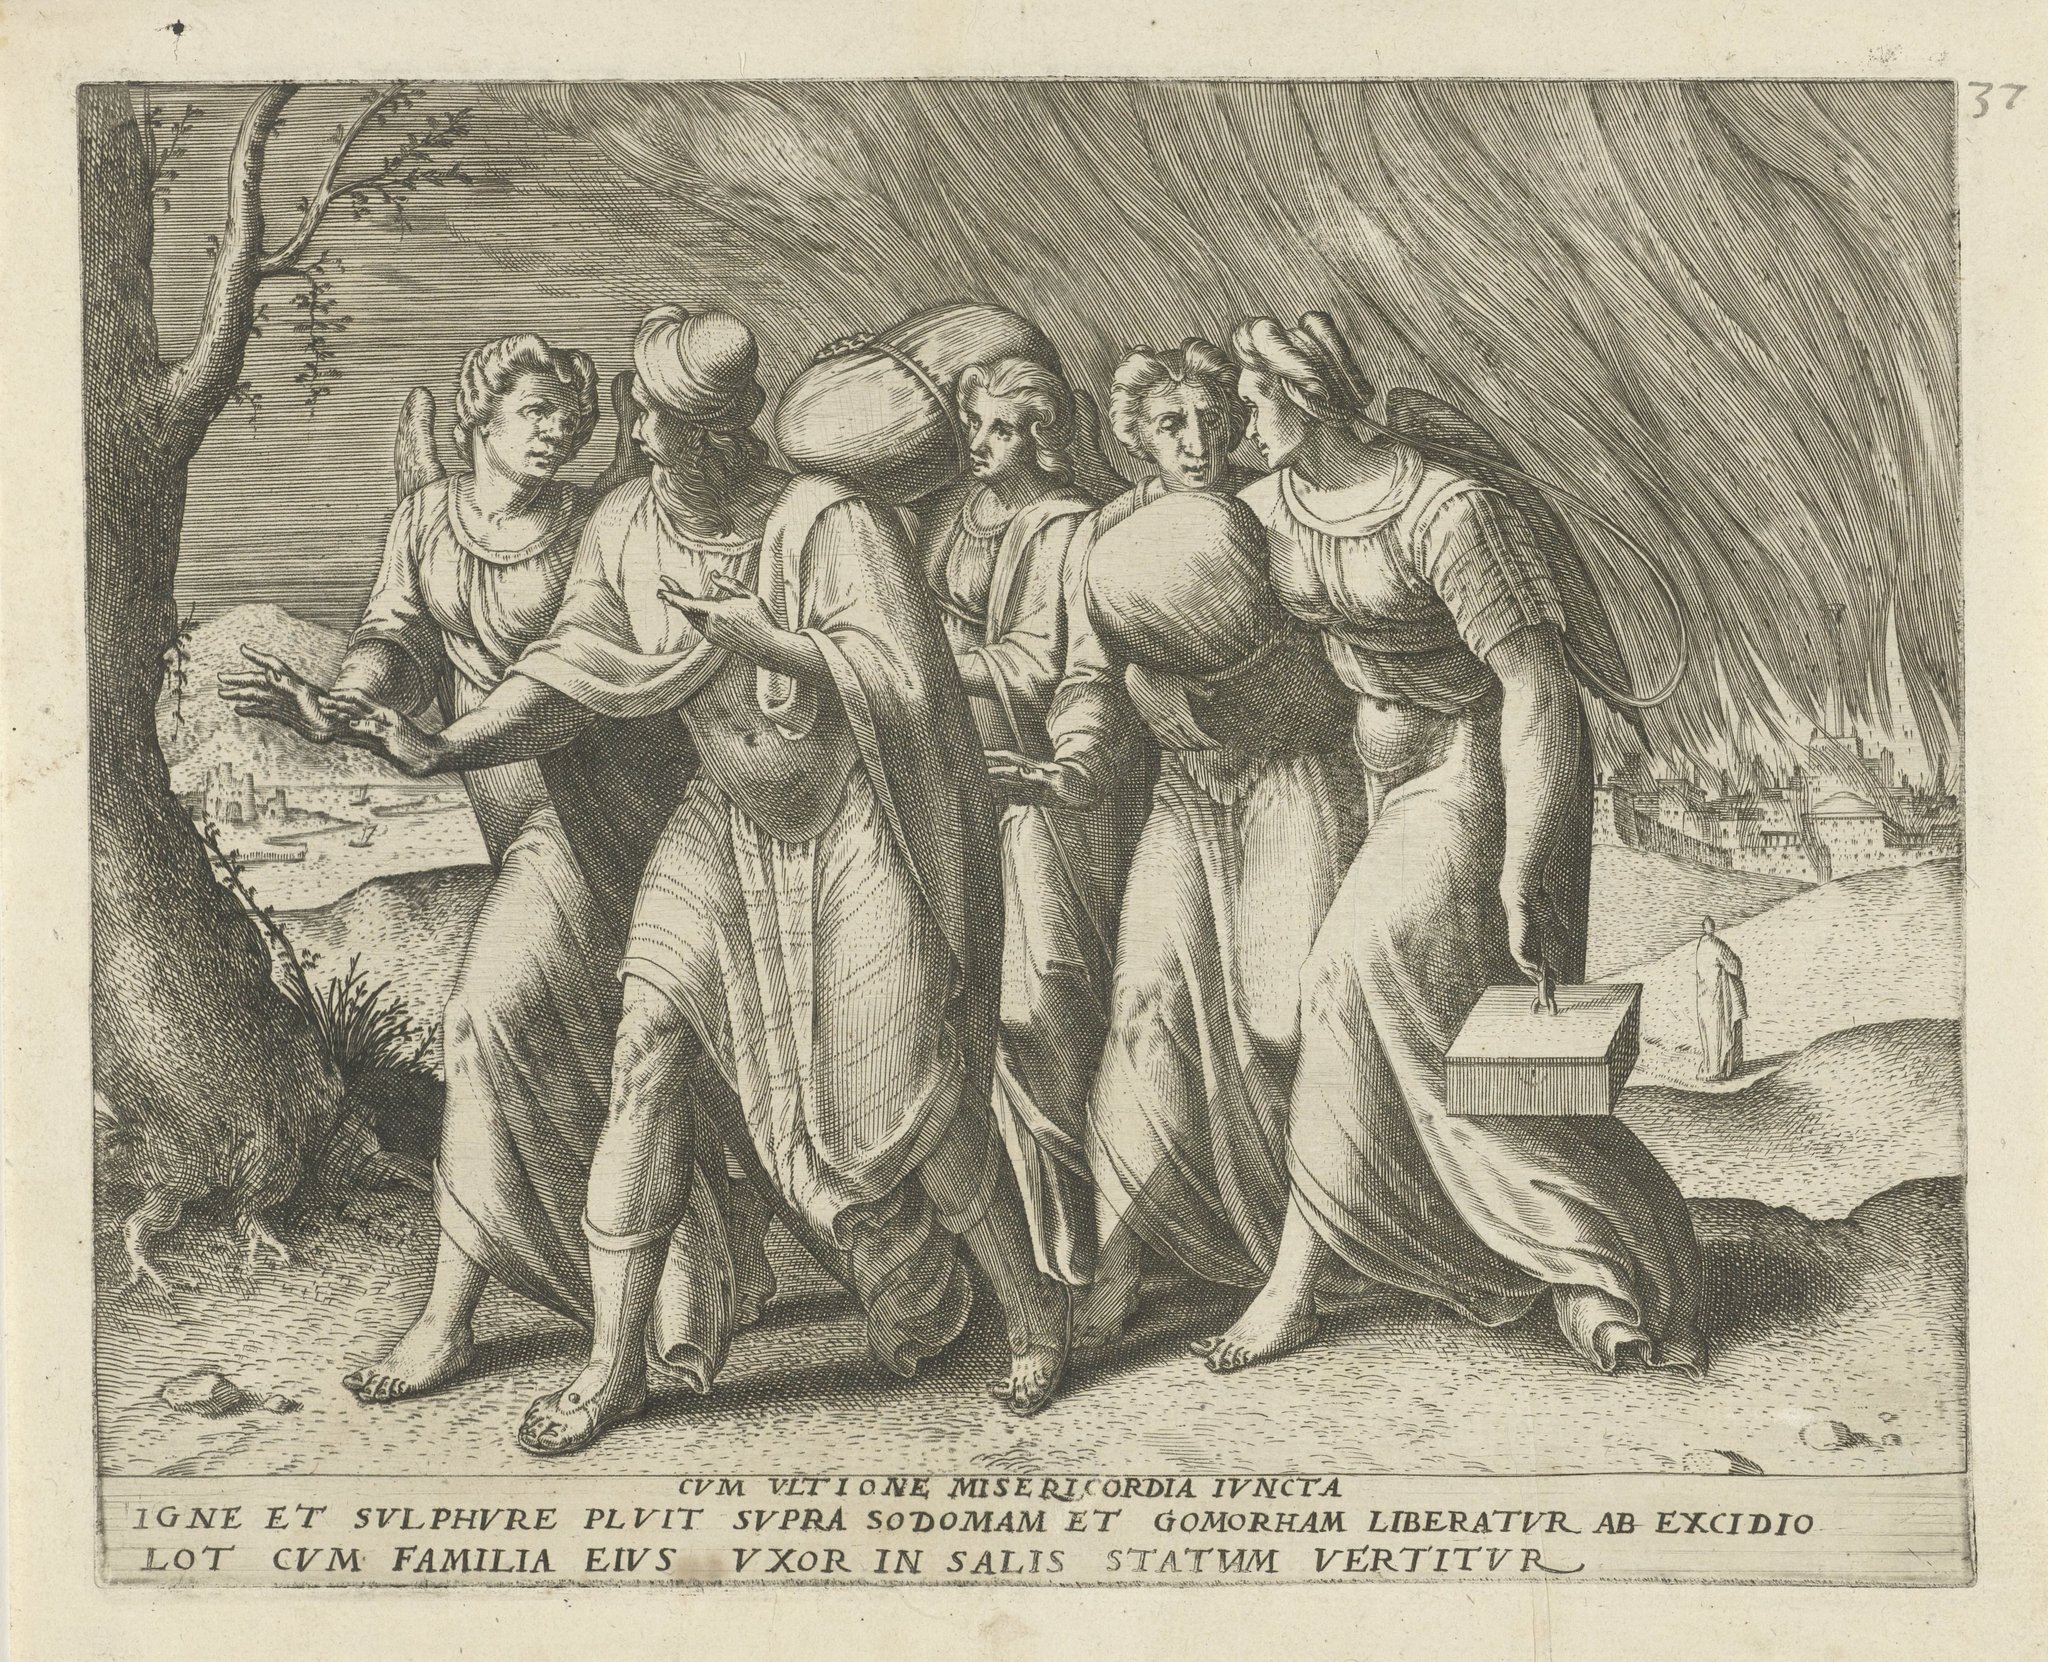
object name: print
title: Lot verlaat Sodom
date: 1550-1570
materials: paper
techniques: engraving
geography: antwerp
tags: the destruction of sodom and gomorrah: lot and his family flee to zoar, carrying their belongings; an angel may be showing the way (genesis 19:24-29)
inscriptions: collector's mark: Lugt 2228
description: Dit is de eerste staat van twee van de eerste editie van deze prent, die mogelijk door Hieronymus Cock werd uitgegeven. De plaat kwam, vermoedelijk na de dood van Cock, in handen van Gerard de Jode. De voorstelling van de plaat werd toen compleet verwijderd en er kwam een iets andere compositie voor in de plaats. Alleen de tekst bleef ongewijzigd. De plaat werd vervolgens gebruikt in: Thesaurus sacrarum historiaru veteris testamenti, elegatissimis imaginibus expressu excelletissimoru in hac arte viroru opera : nuc primu in luce editus. Antwerpen: Gerard de Jode, 1579. Van die tweede editie, toegeschreven aan Hans Collaert (I), bestaan drie staten.